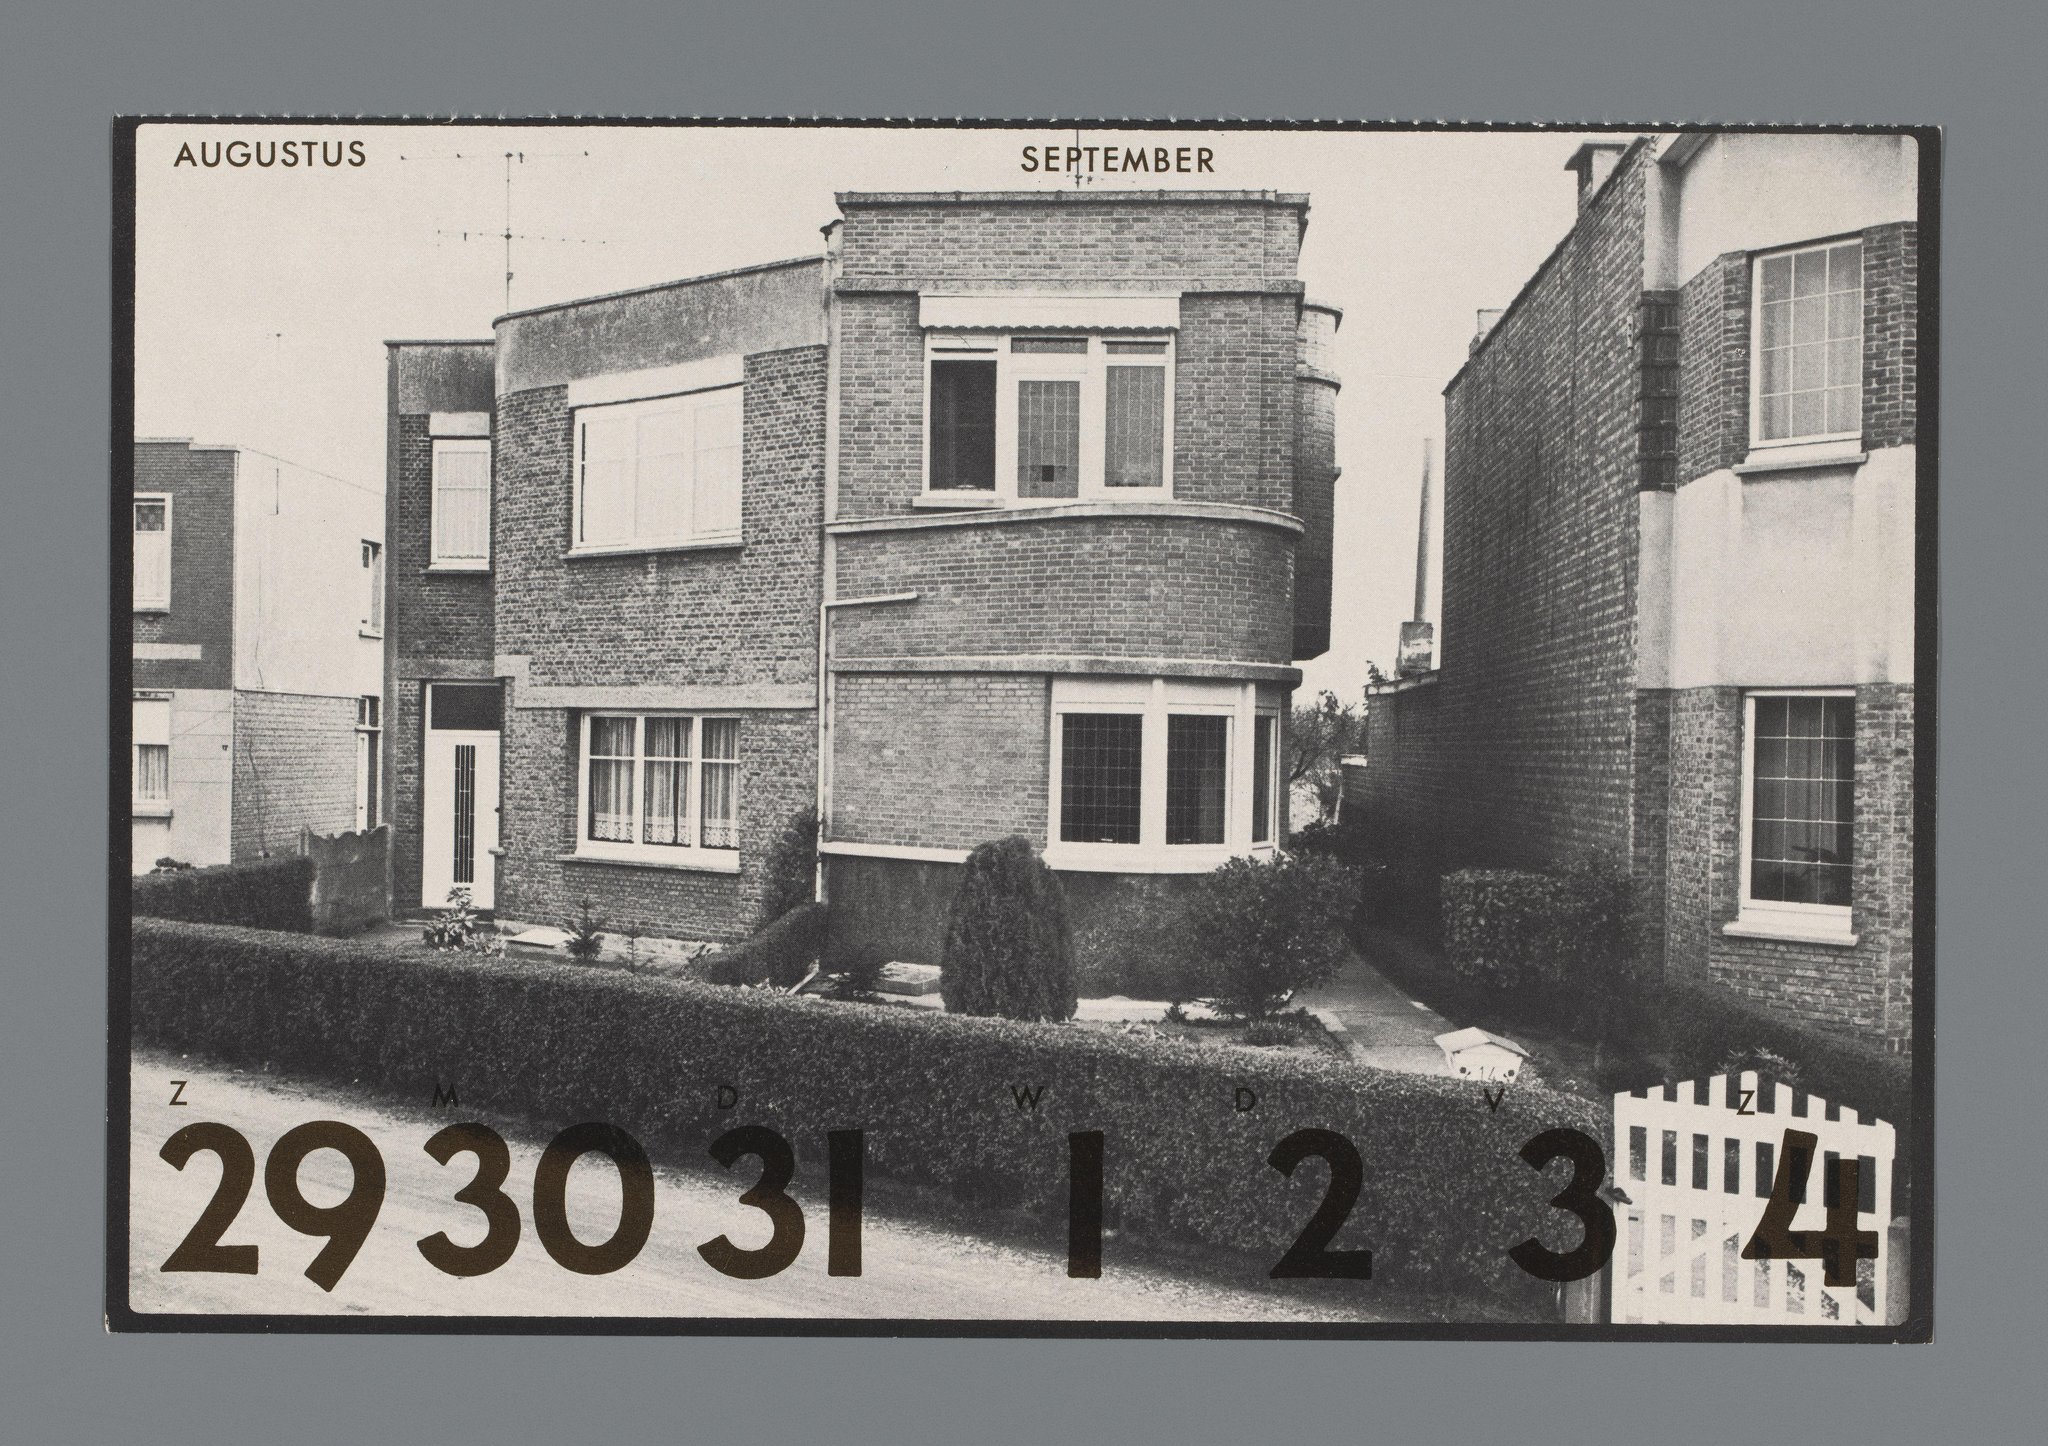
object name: photograph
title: België. Huizen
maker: Anonymous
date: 1900-1950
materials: paper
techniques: offset printed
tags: belgium